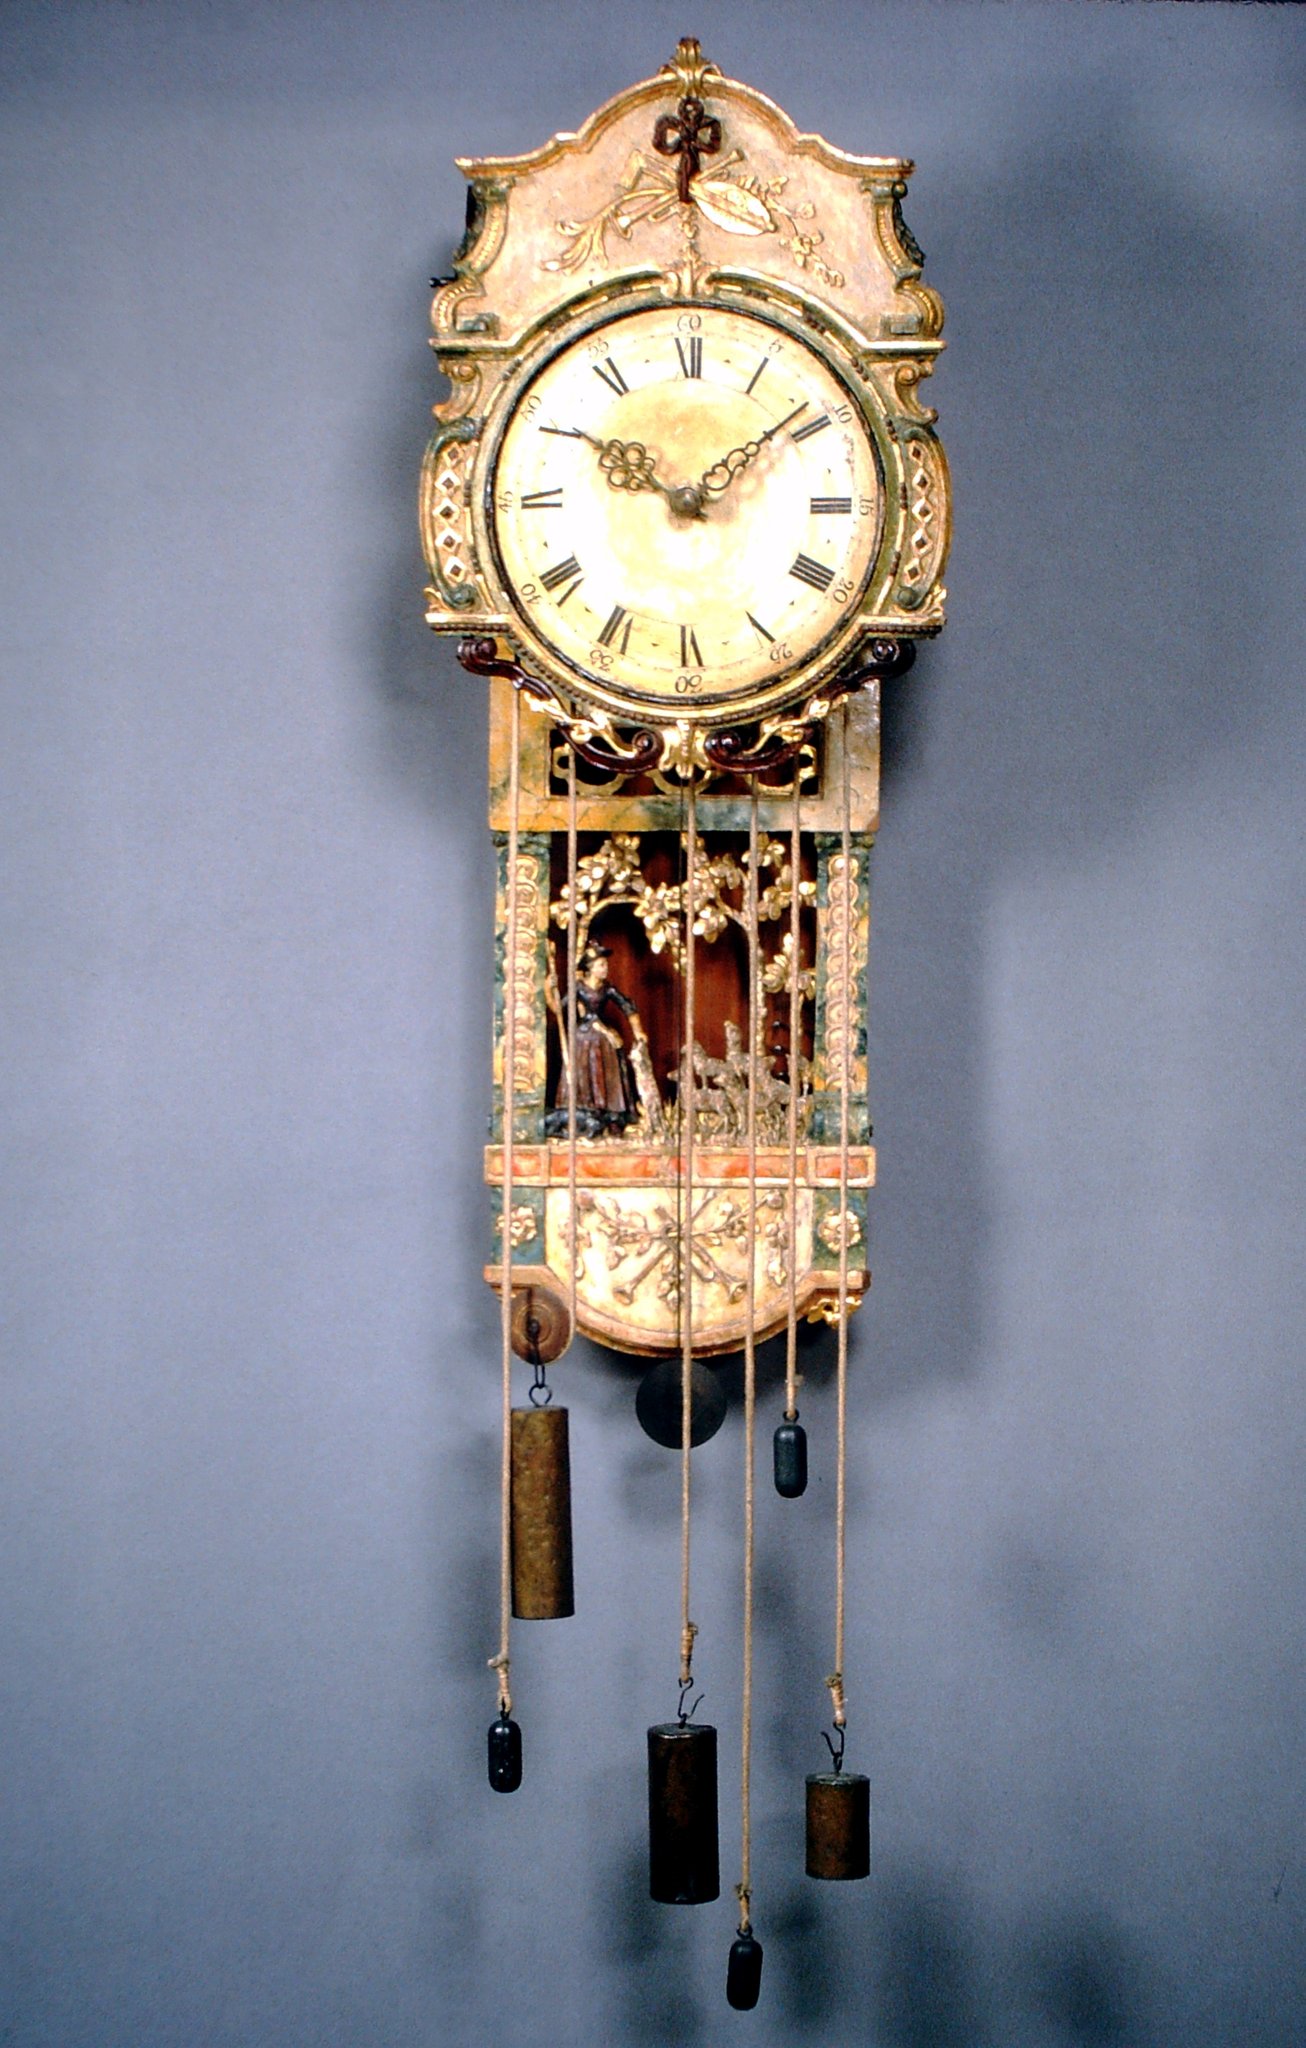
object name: musical clock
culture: german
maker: martin vanlo?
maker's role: maker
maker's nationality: german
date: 1800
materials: metal, wood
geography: germany